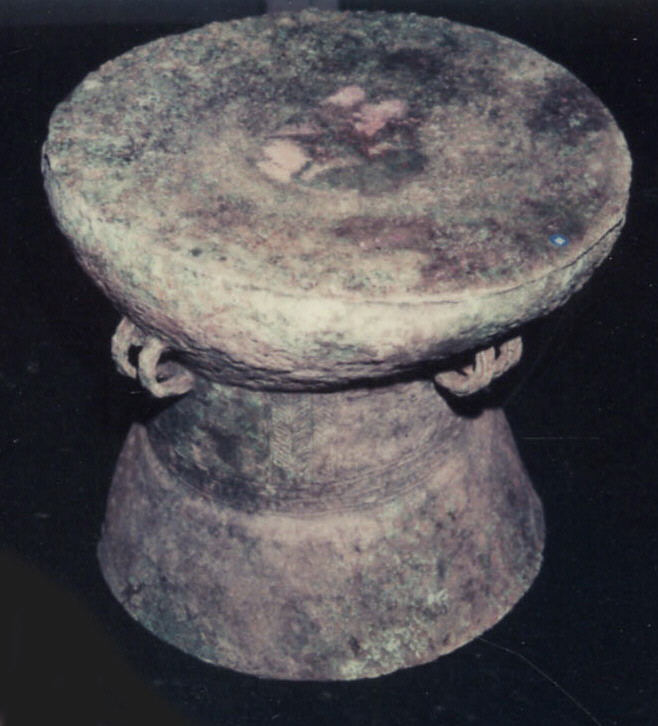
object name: drum and fragment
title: Drum and Four Fragments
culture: vietnamese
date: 500 BCE-300 CE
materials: bronze